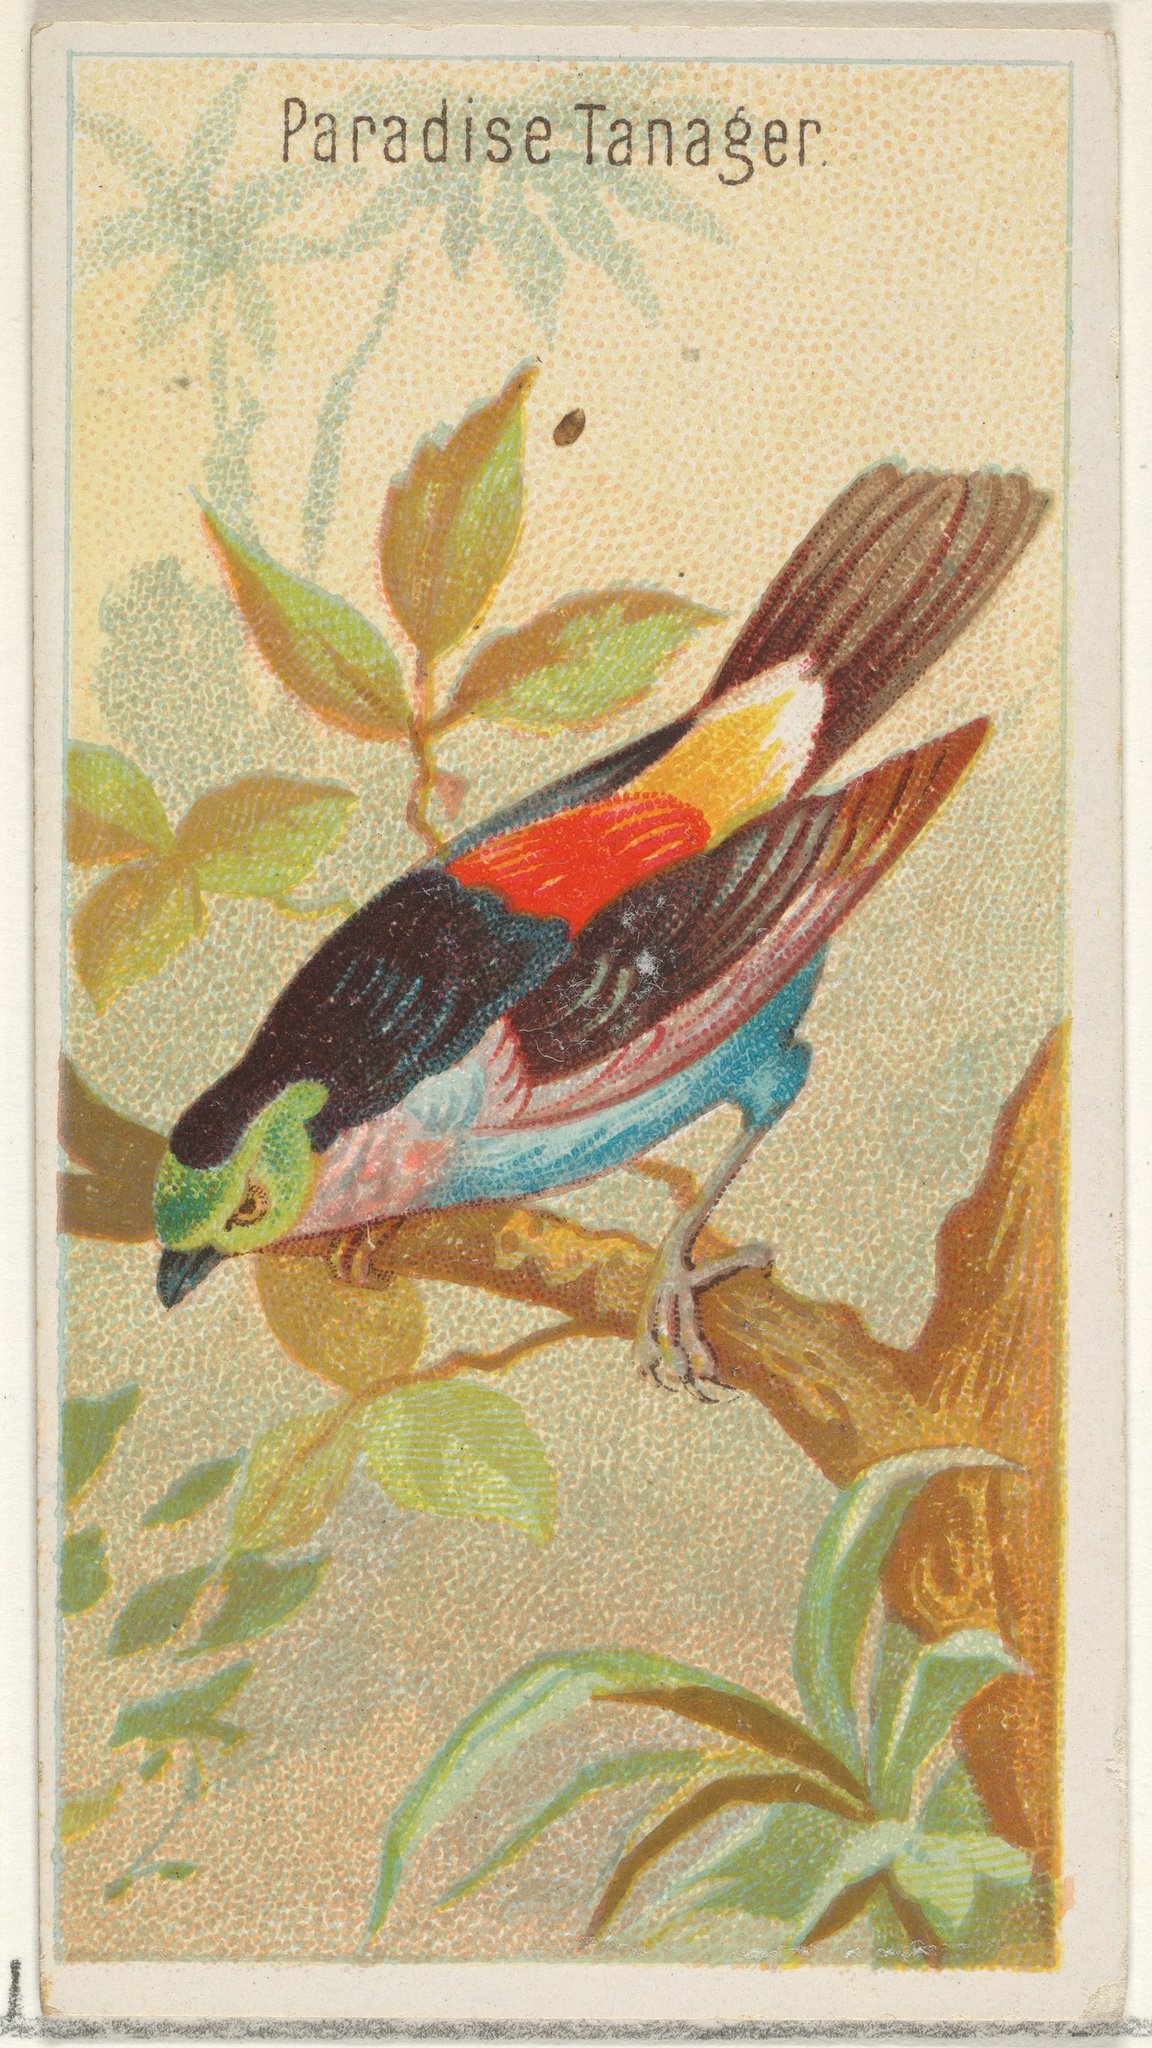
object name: print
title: Paradise Tanager, from the Birds of the Tropics series (N5) for Allen & Ginter Cigarettes Brands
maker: allen & ginter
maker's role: publisher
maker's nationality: american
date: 1889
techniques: color lithograph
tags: birds